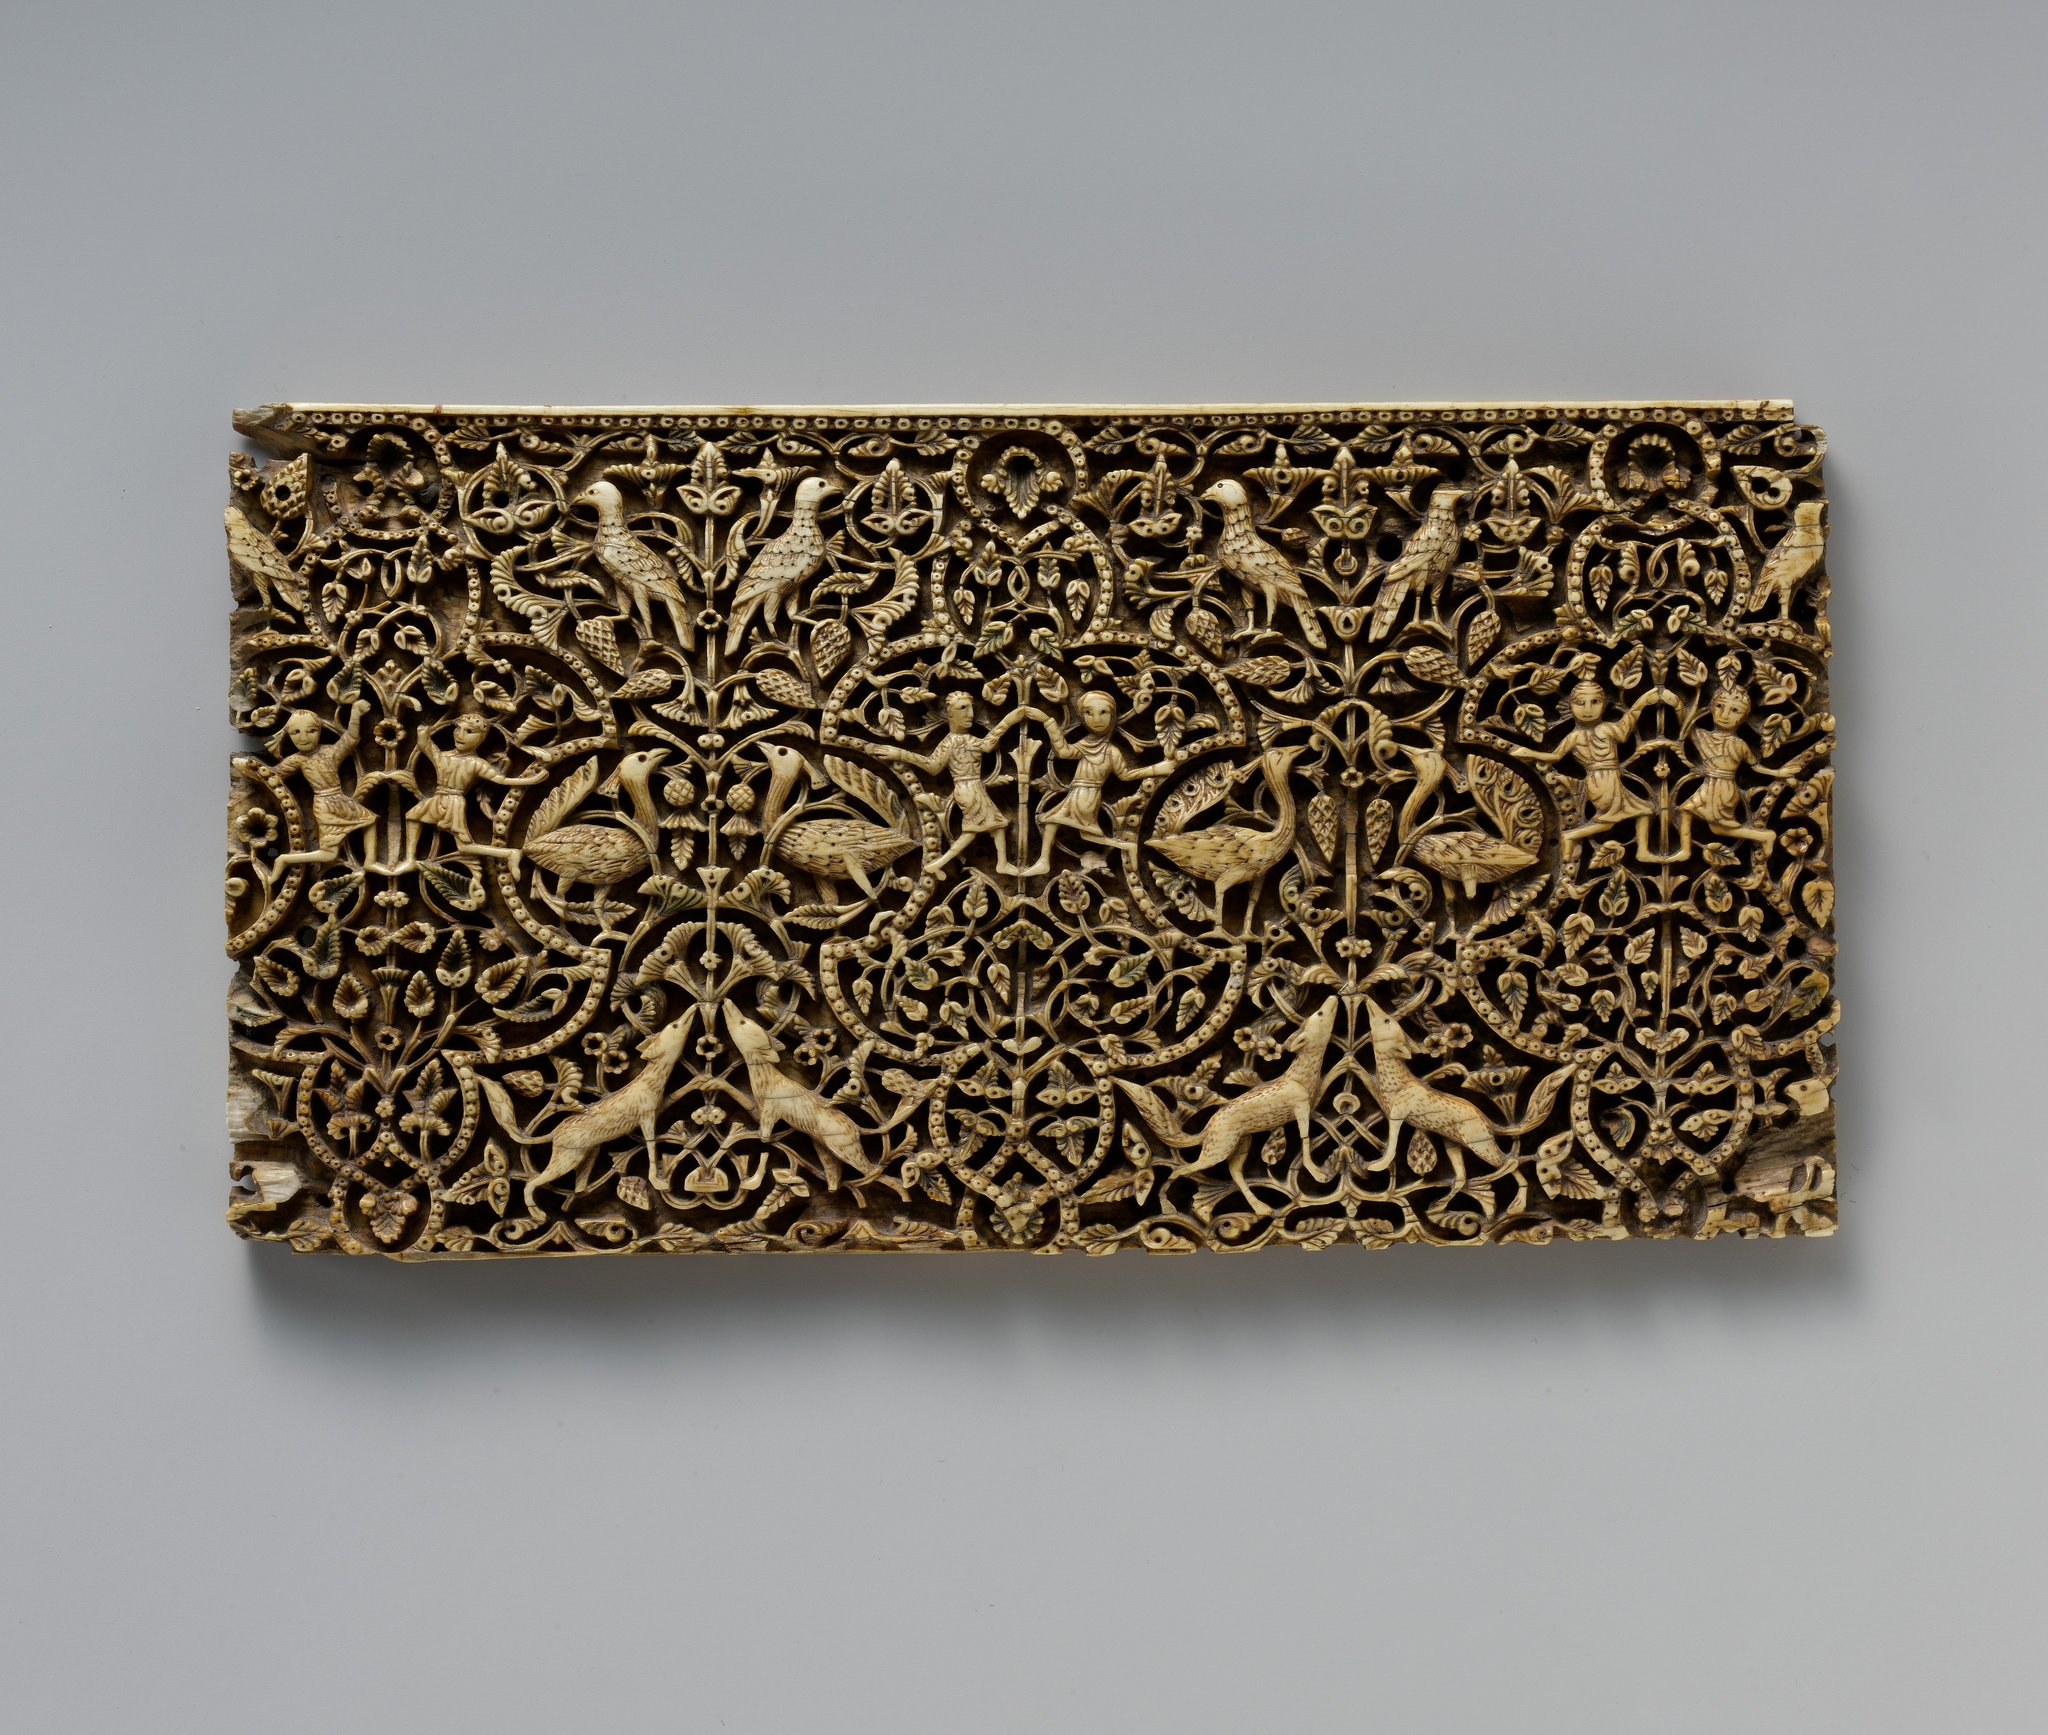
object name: panel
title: Panel from a Rectangular Box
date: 901-1033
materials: ivory, pigment, stone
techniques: carving, inlay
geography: spain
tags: birds,peacocks,foxes,dancers